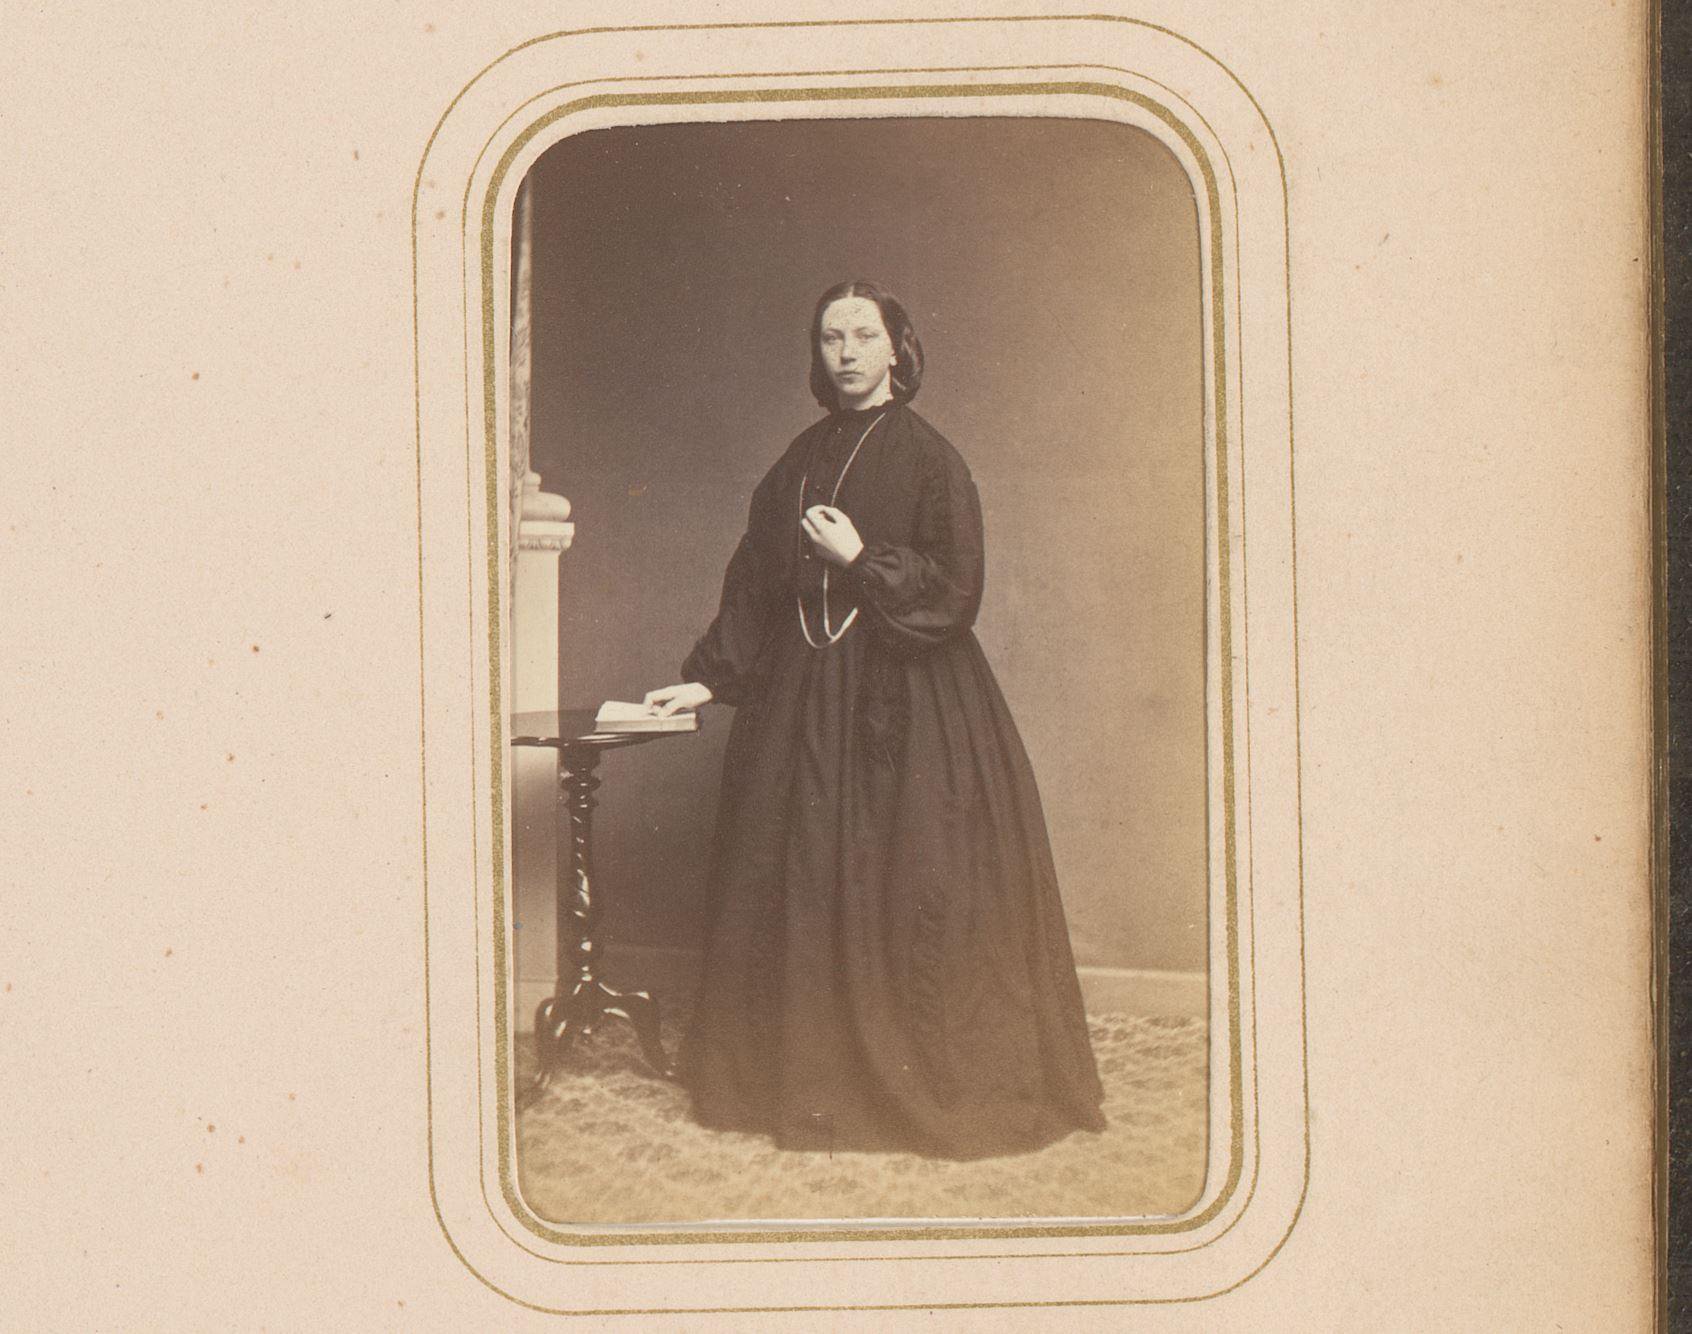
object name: album leaf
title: Portret van een vrouw, staand bij een tafel met een hand op een open boek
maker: o.c. smith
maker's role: fotograaf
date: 1860-1900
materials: cardboard, photographic support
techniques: albumen print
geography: stroud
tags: historical persons - bb - woman, book - mm - book open, table, standing figure - aa - female human figure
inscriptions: inscription: ‘O. C. SMITH./ STROUD.’